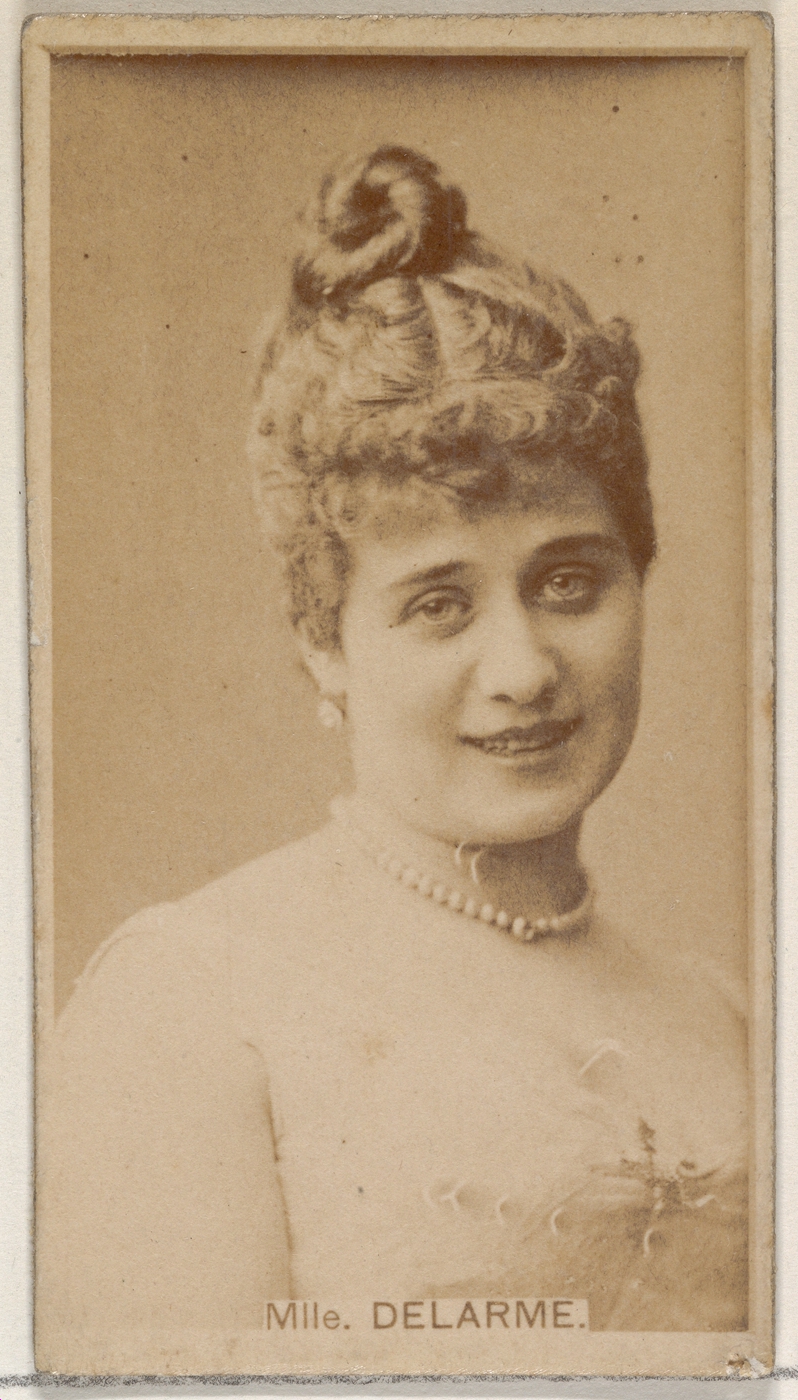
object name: photograph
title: Mlle. Delarme, from the Actors and Actresses series (N45, Type 8) for Virginia Brights Cigarettes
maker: allen & ginter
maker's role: publisher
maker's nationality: american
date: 1888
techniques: albumen silver print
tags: portraits,women,actresses